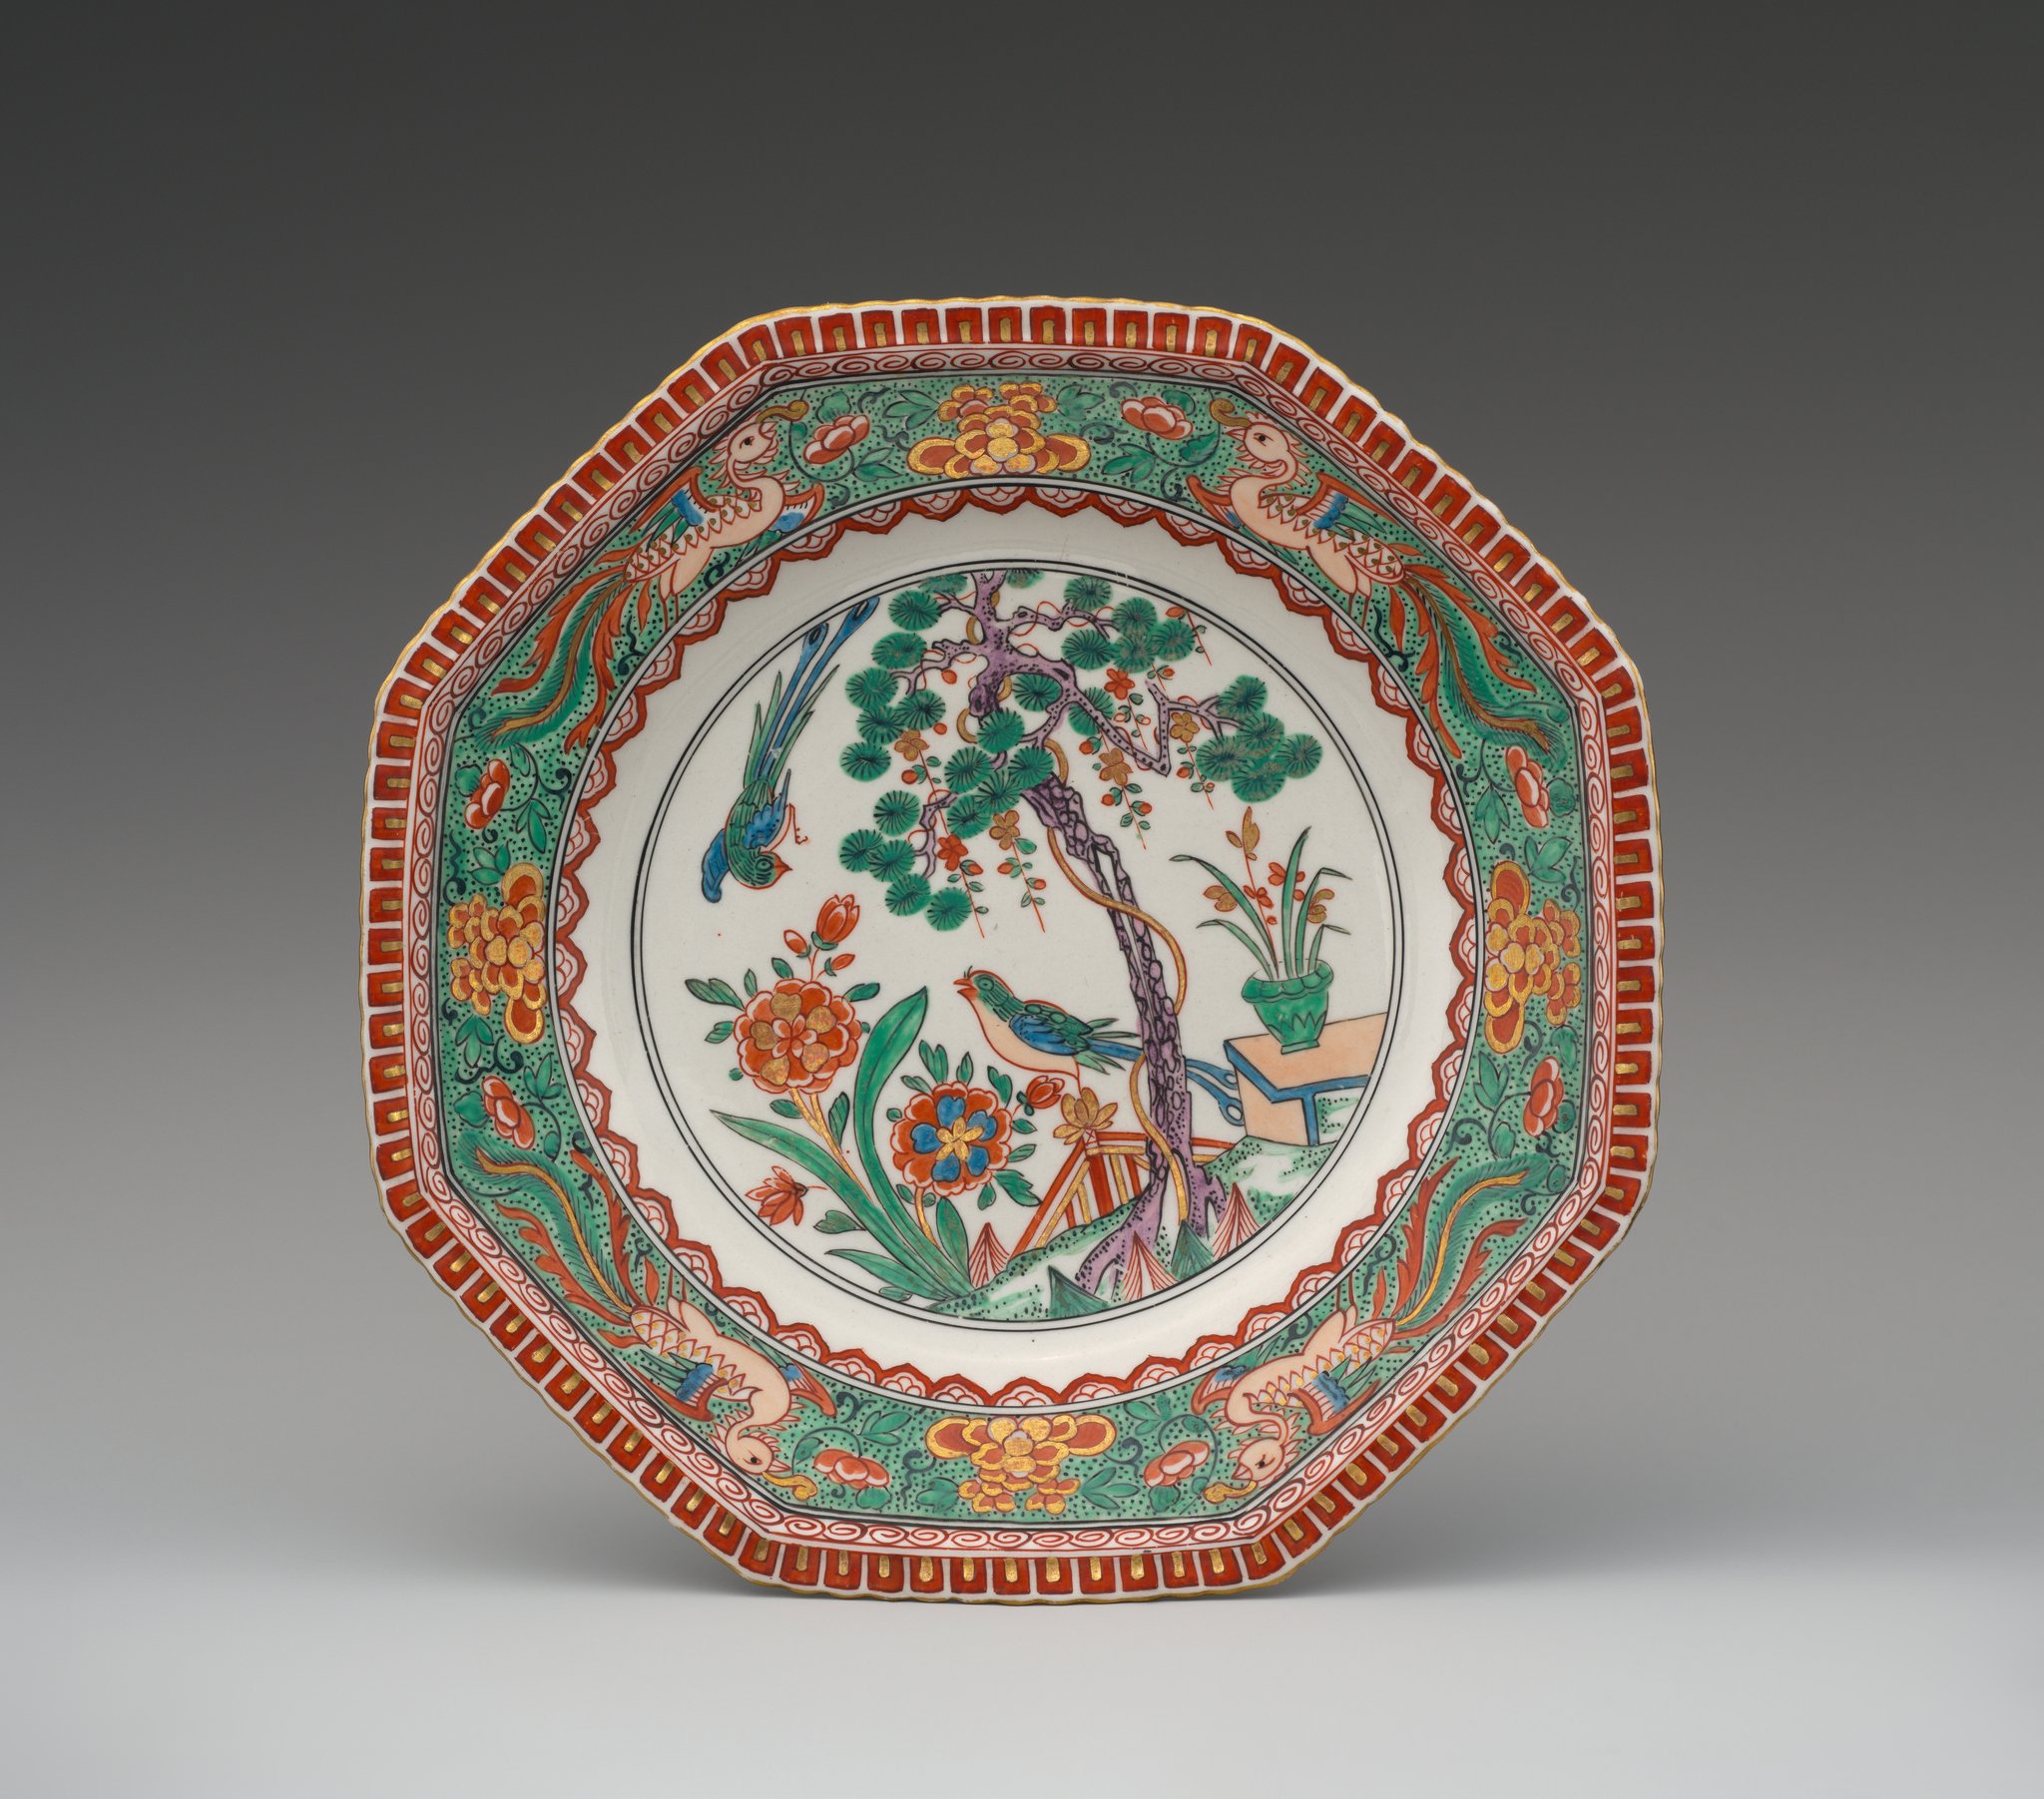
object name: soup plate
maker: crown derby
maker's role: maker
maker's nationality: british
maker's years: 1750-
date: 1701-1900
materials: soft paste porcelain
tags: birds,dragons,trees